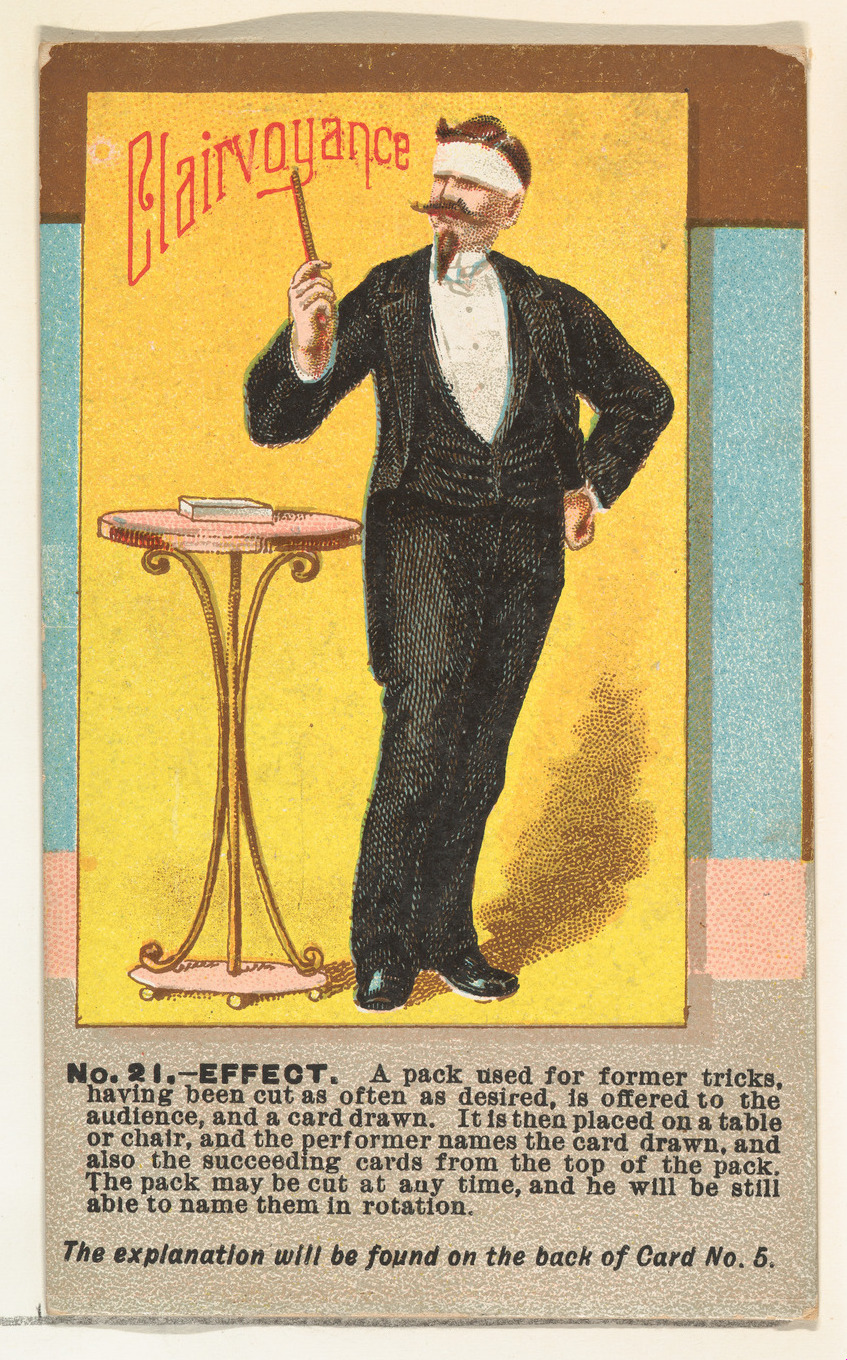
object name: print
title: Number 21, Clairvoyance, from the Tricks with Cards series (N138) issued by W. Duke, Sons & Co. to promote Honest Long Cut Tobacco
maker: w. duke, sons & co.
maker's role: publisher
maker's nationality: american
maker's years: 1870-1920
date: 1887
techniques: color lithograph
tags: men,magic